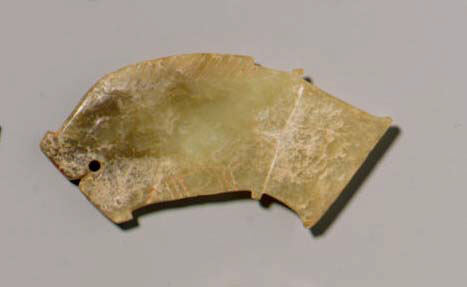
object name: plaque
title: Plaque in the Shape of a Fish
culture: chinese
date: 1200-1001 BCE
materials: jade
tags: fish